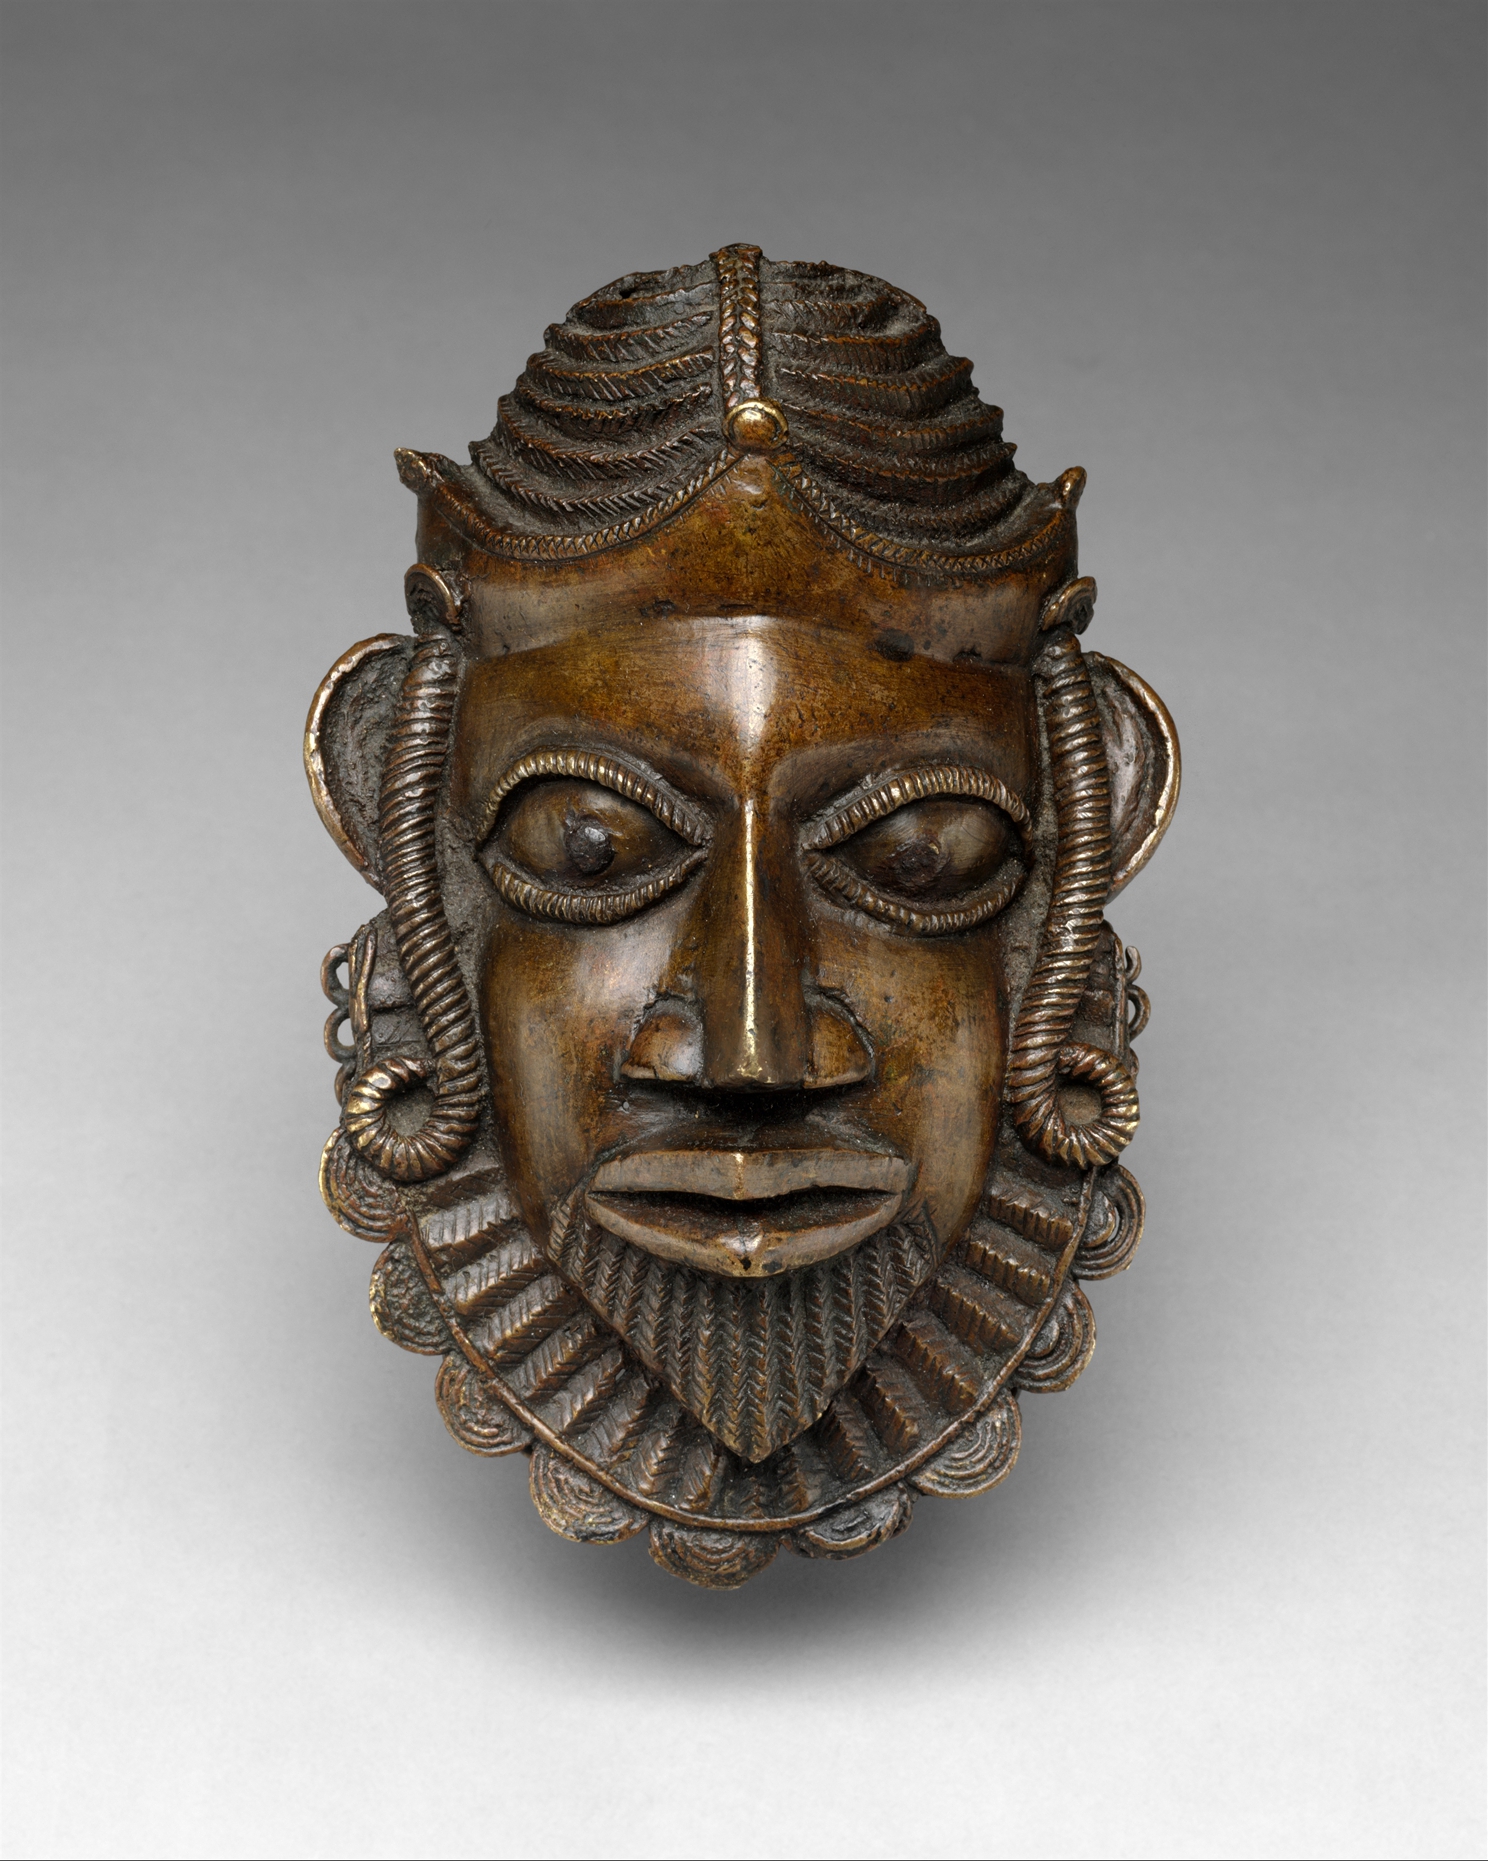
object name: hip ornament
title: Hip ornament with Portuguese head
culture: edo period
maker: ìgùn ẹ́rọ̀nwwọ̀n (brass-casting guild) artists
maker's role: artist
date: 1501-1900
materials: brass, iron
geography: nigeria